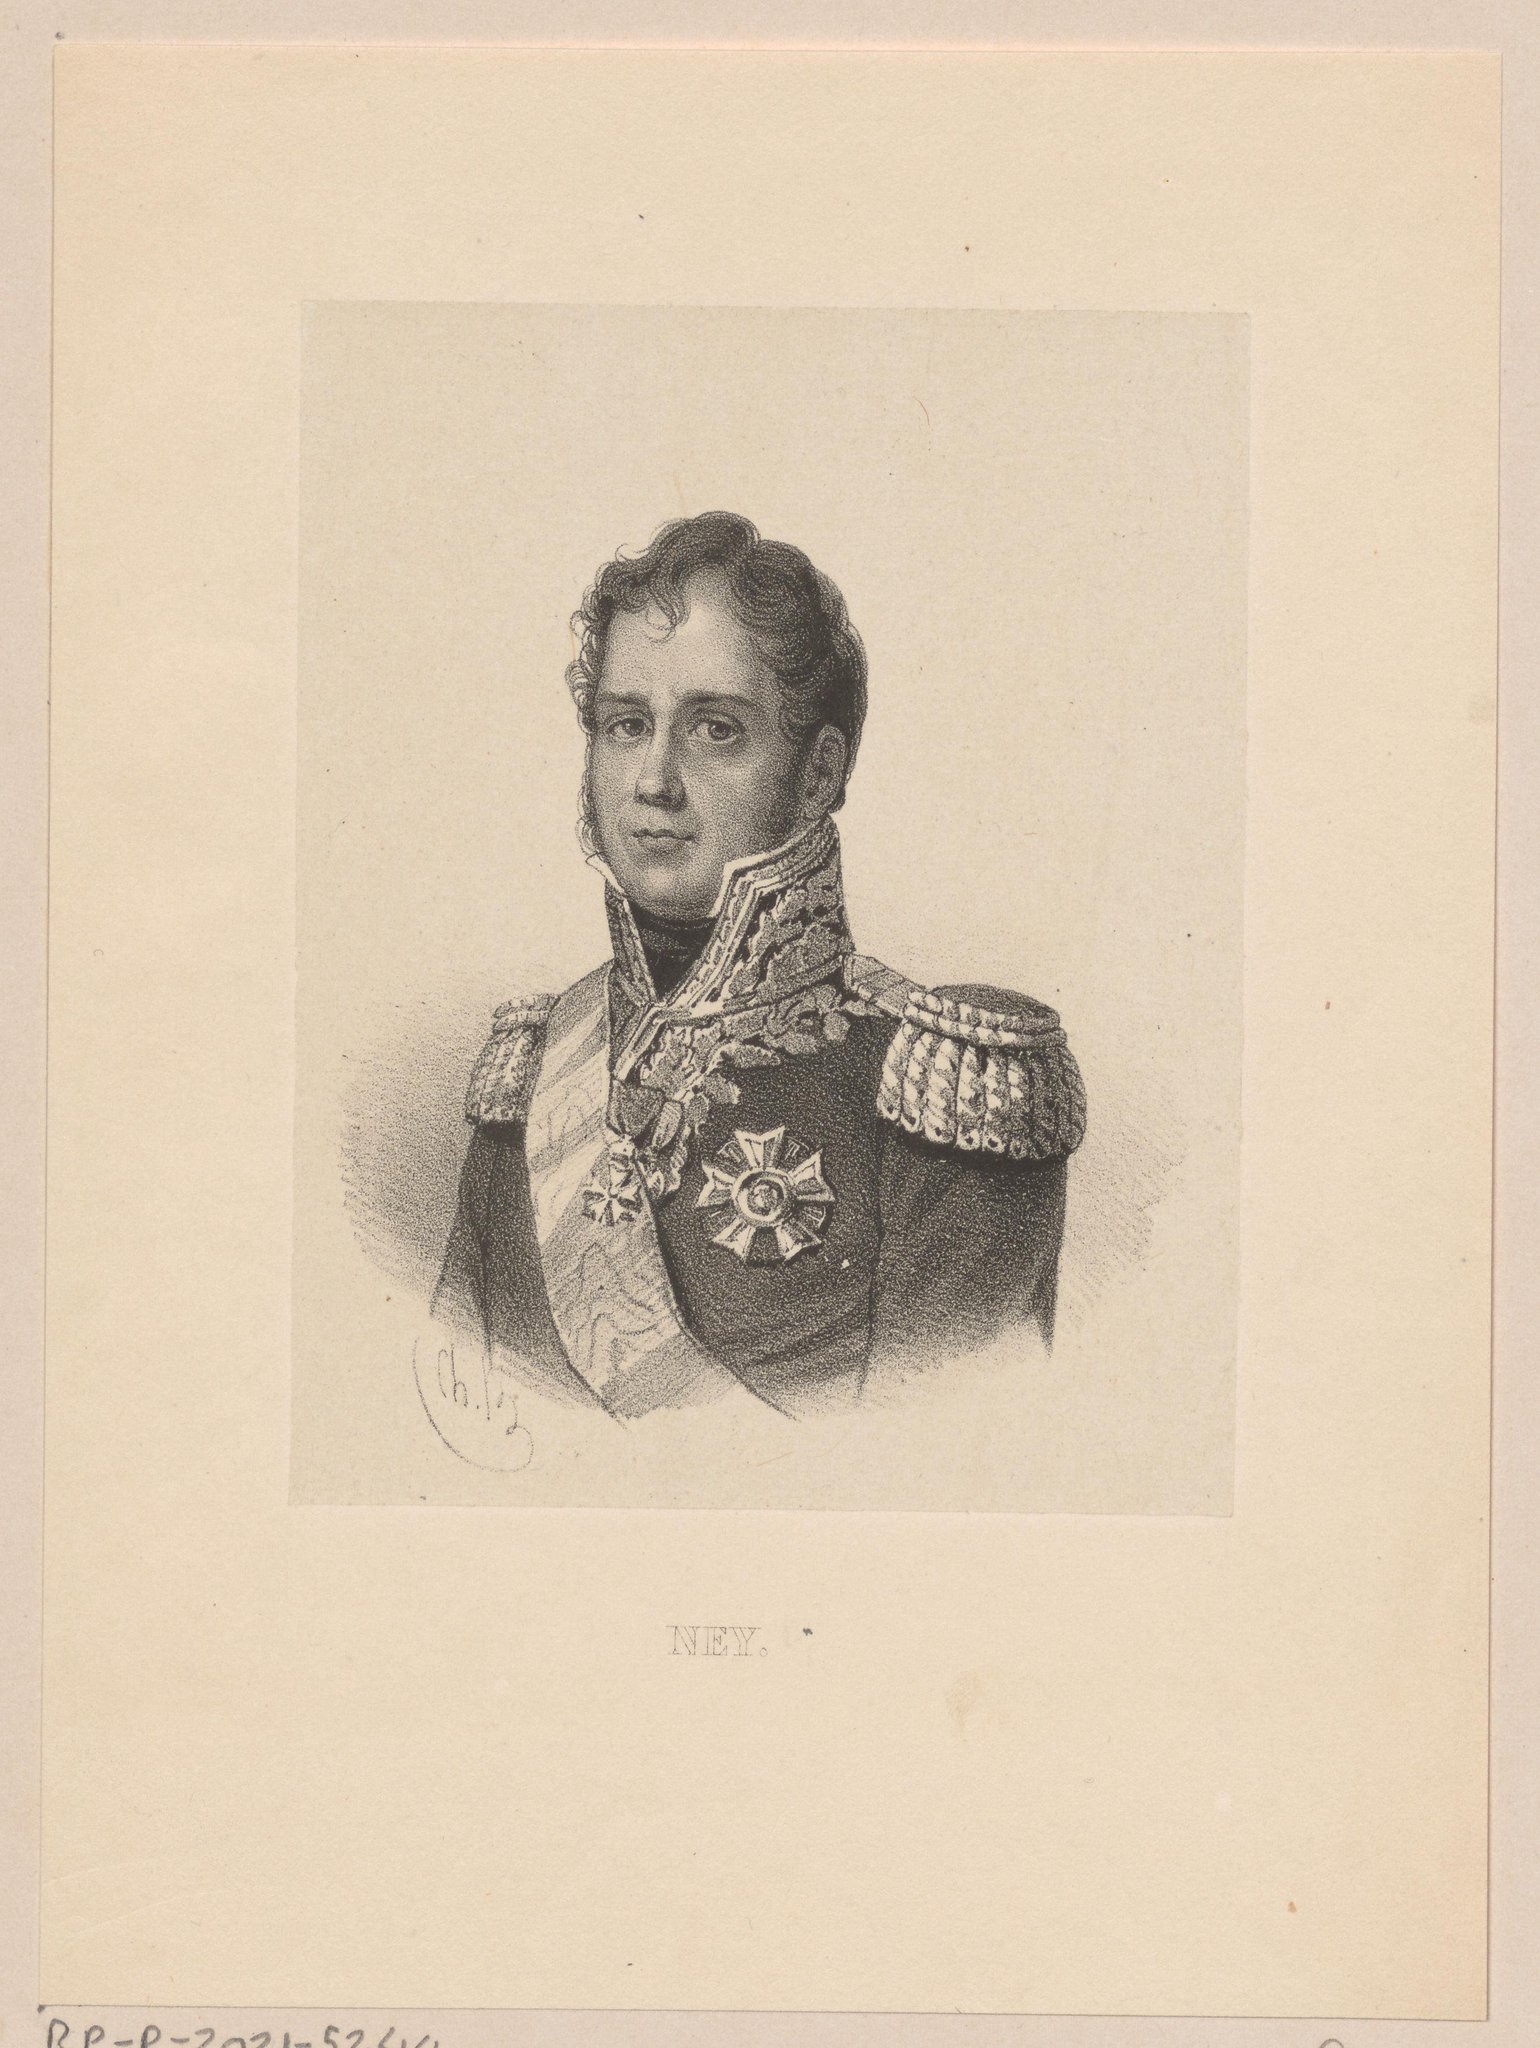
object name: print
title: Portret van Michel Ney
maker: Anonymous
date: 1815-1849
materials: paper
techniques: lithograph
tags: paris, commander-in-chief, general, marshal, historical persons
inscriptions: monogram: ‘Ch. B(?)’